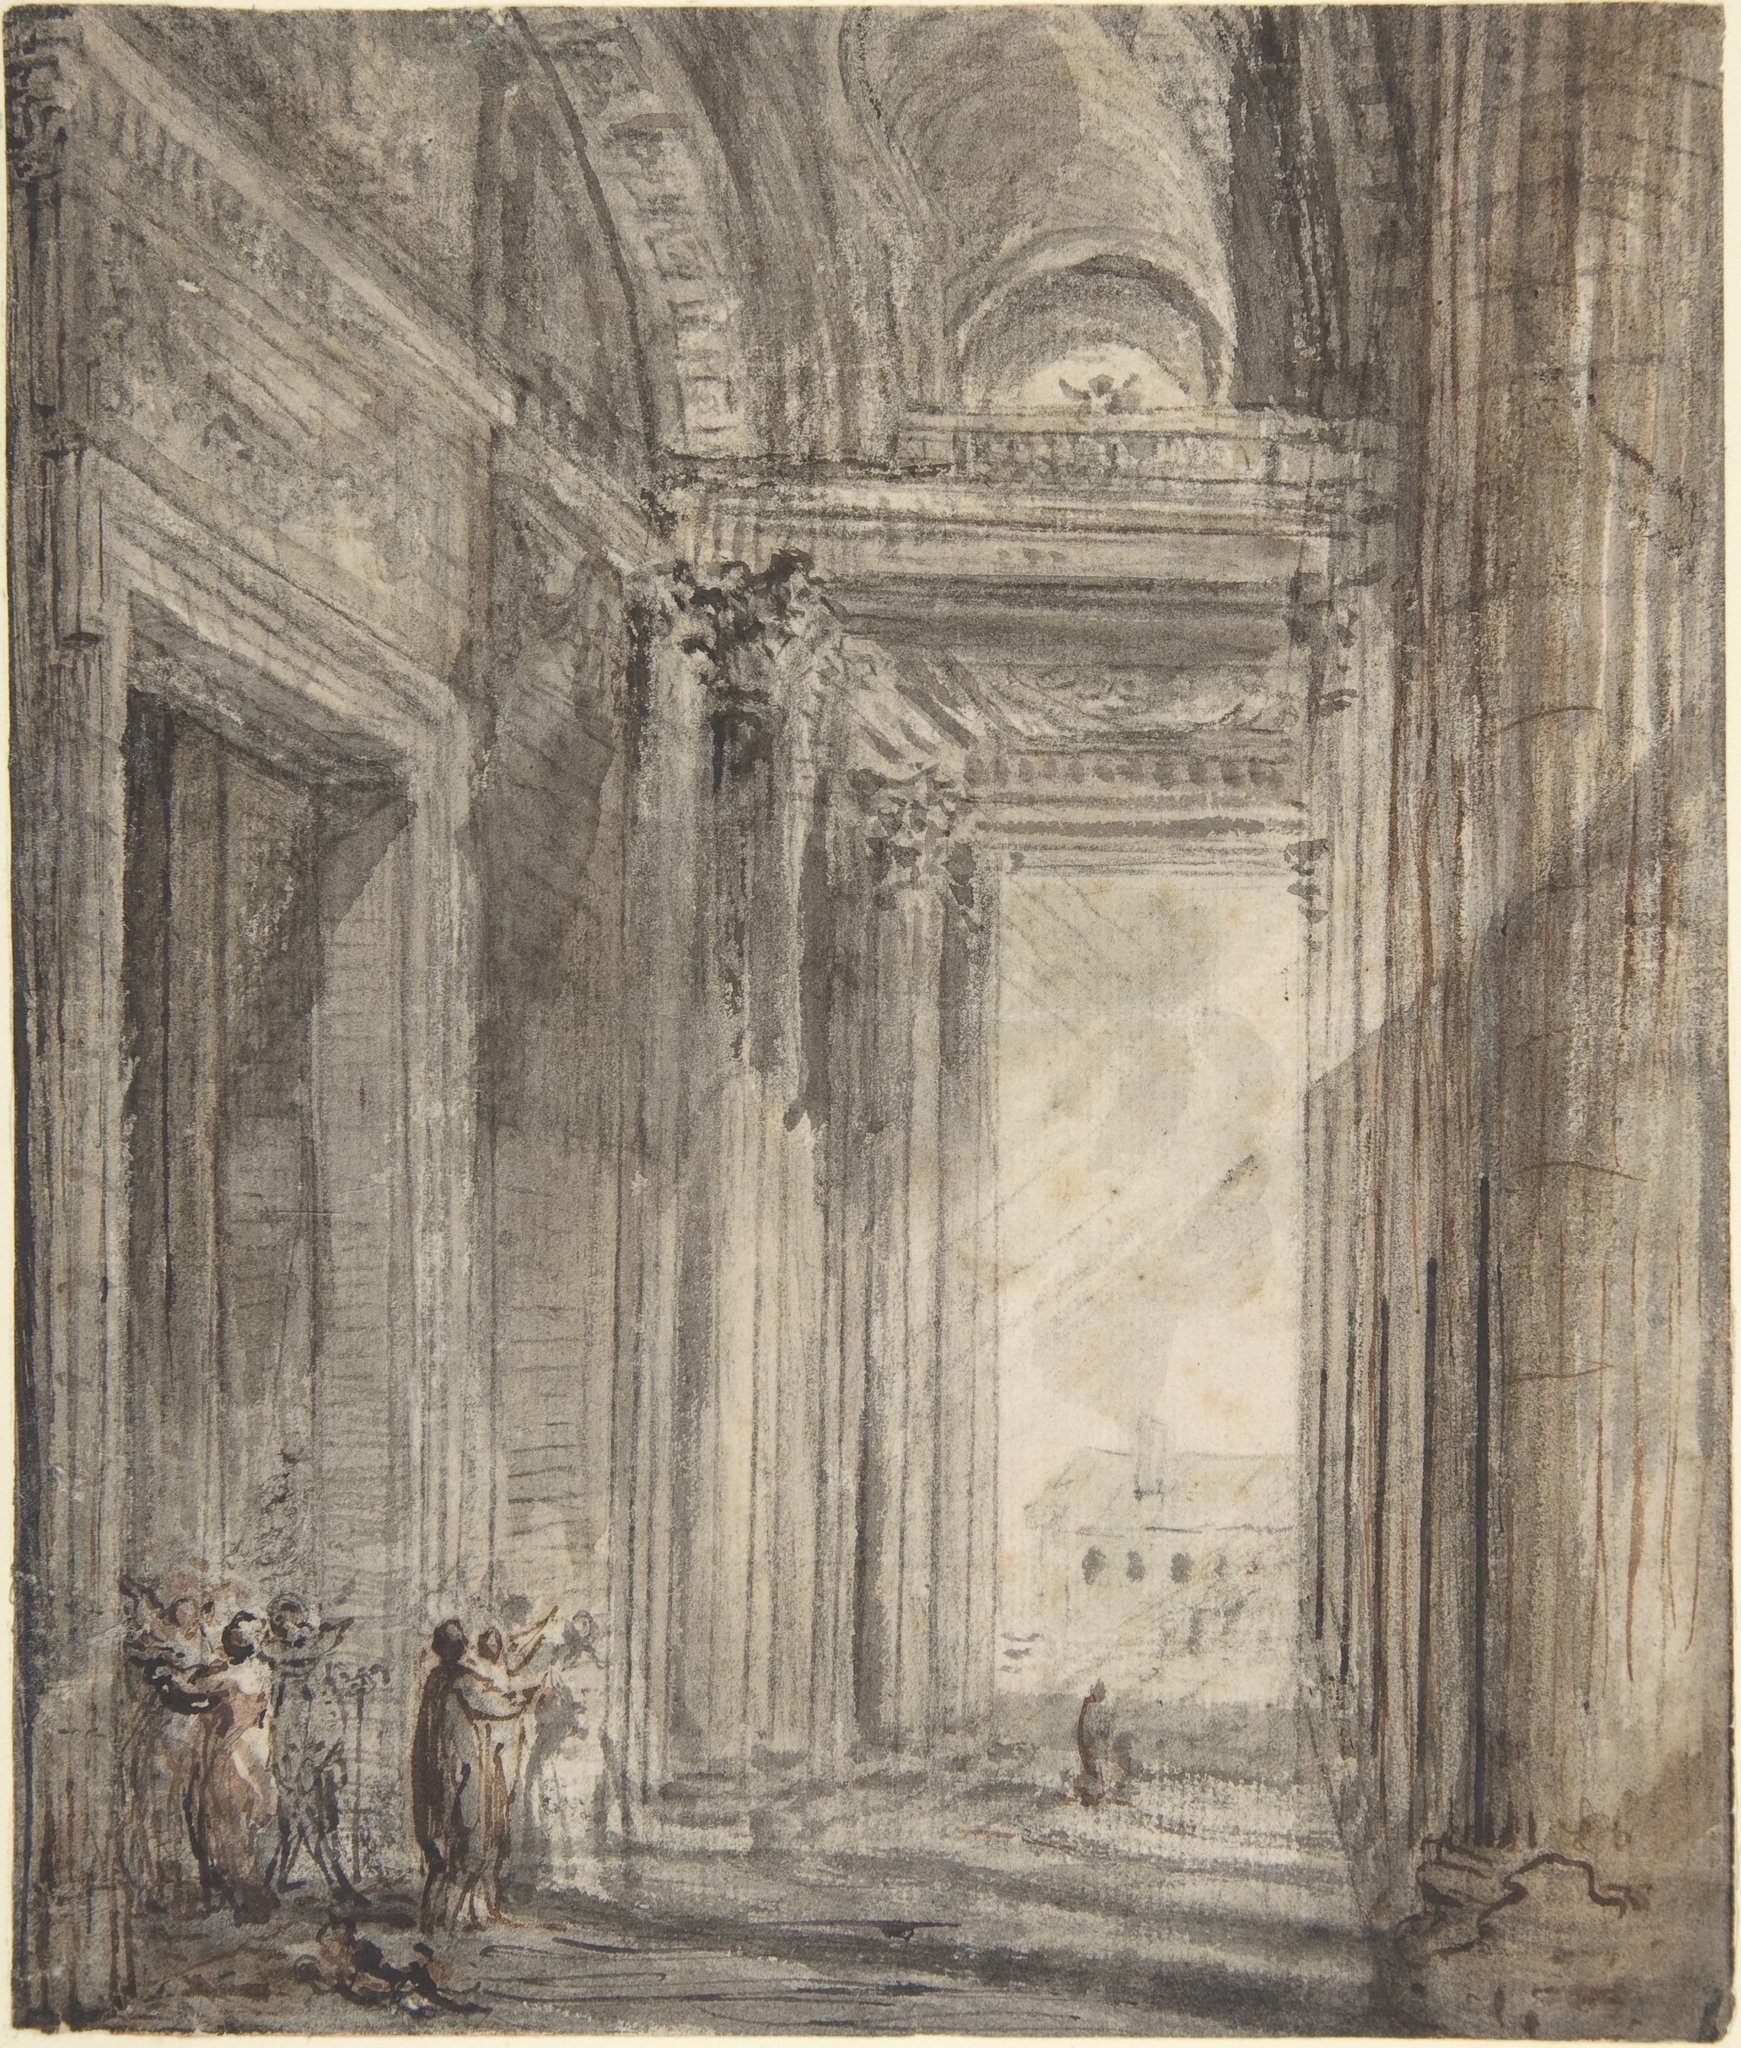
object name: drawing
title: Figures in the portico of the church of Saint Genevieve, Paris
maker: gabriel de saint-aubin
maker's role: artist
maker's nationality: french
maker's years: 1724-1780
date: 1776-1779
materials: chalk, ink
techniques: brush, pen, wash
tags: human figures,columns